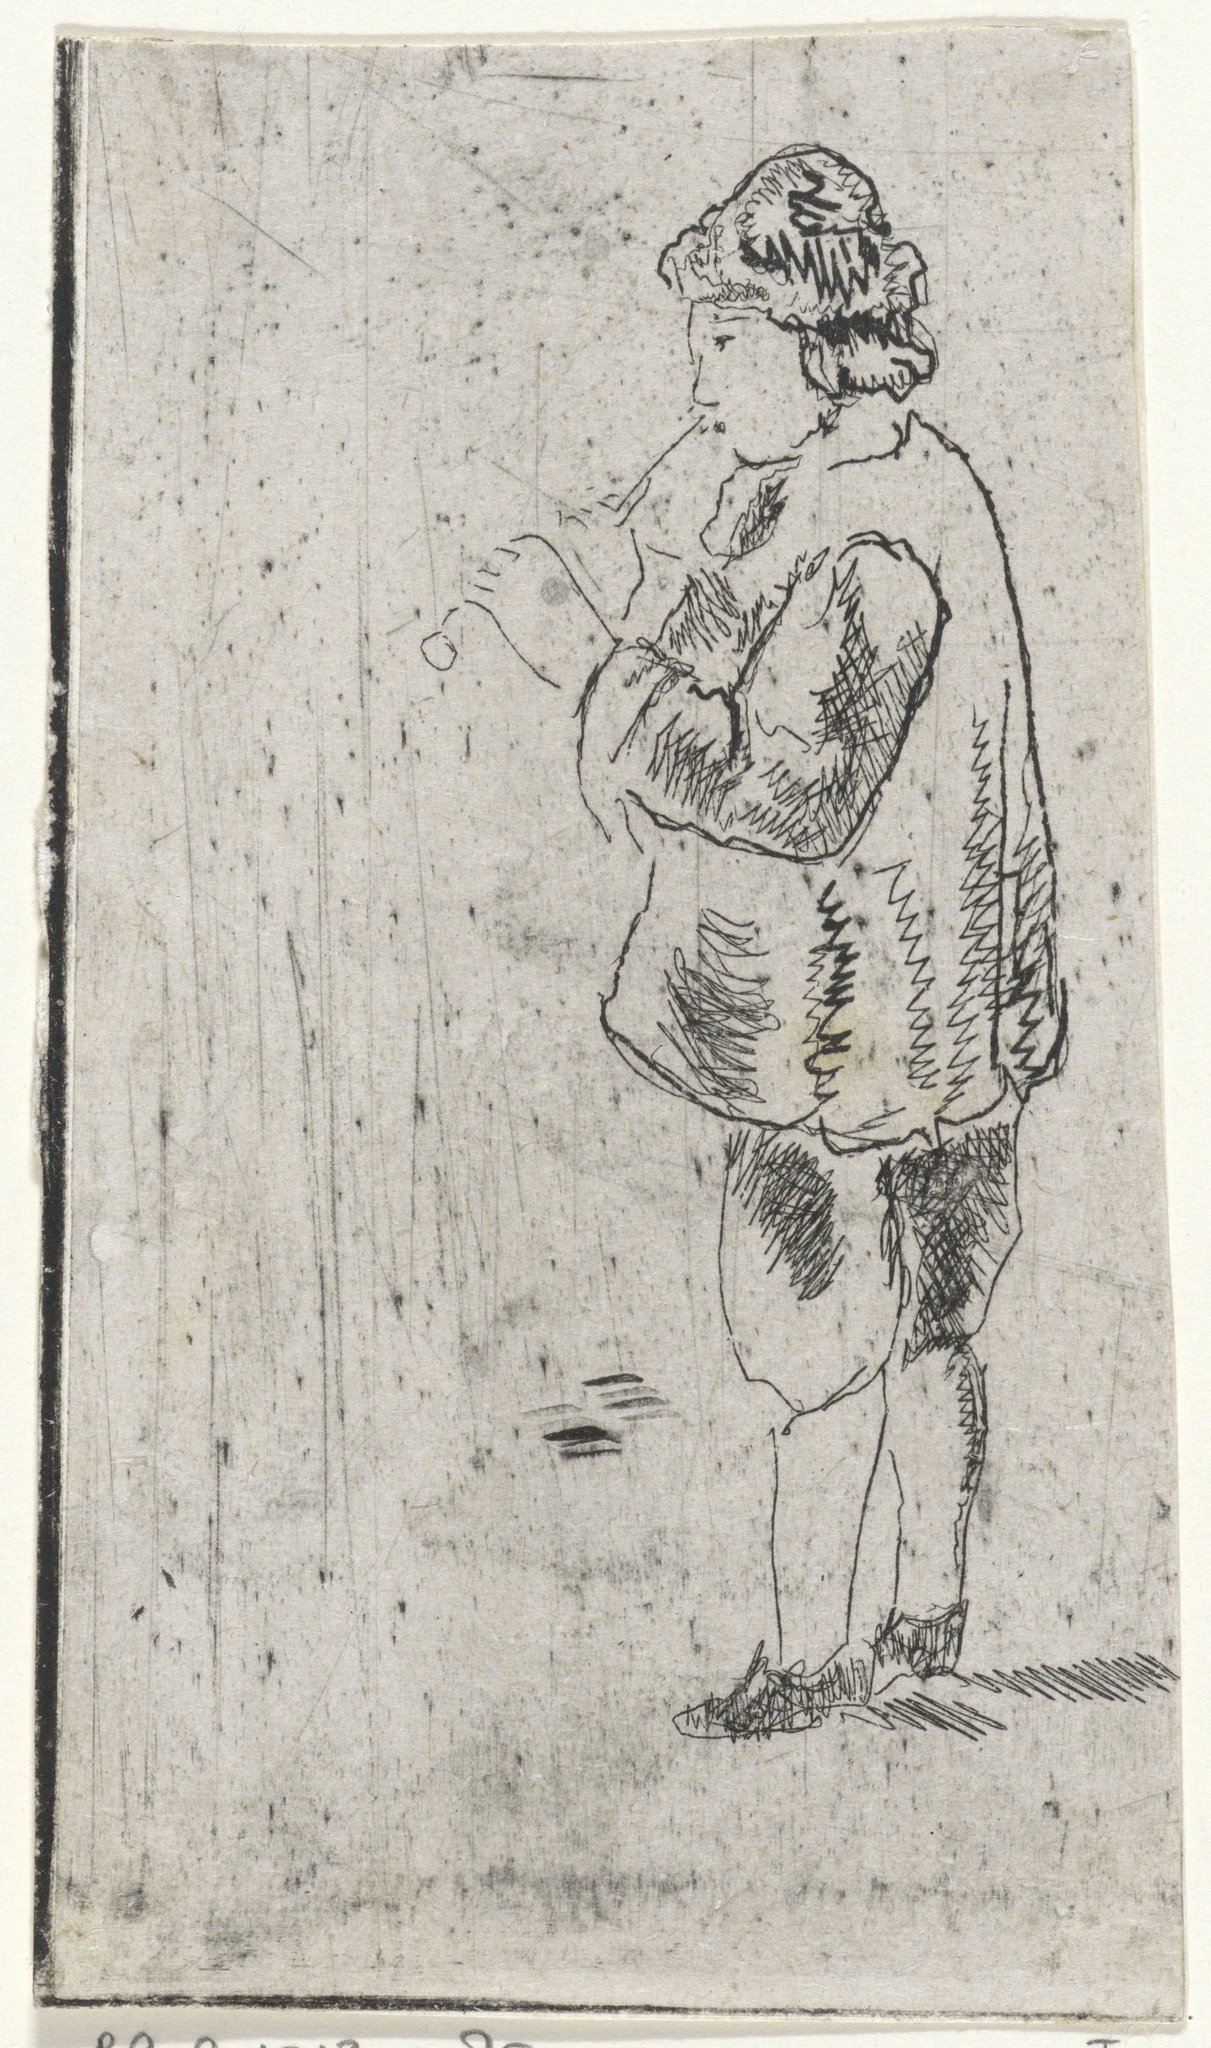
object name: print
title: Fluitspelende jongen met hond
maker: arnoud schaepkens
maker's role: print maker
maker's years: 1816-1904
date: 1831-1904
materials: paper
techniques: etching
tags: youth, adolescent, flute, aulos, tibia, dog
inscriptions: collector's mark: Lugt 2228